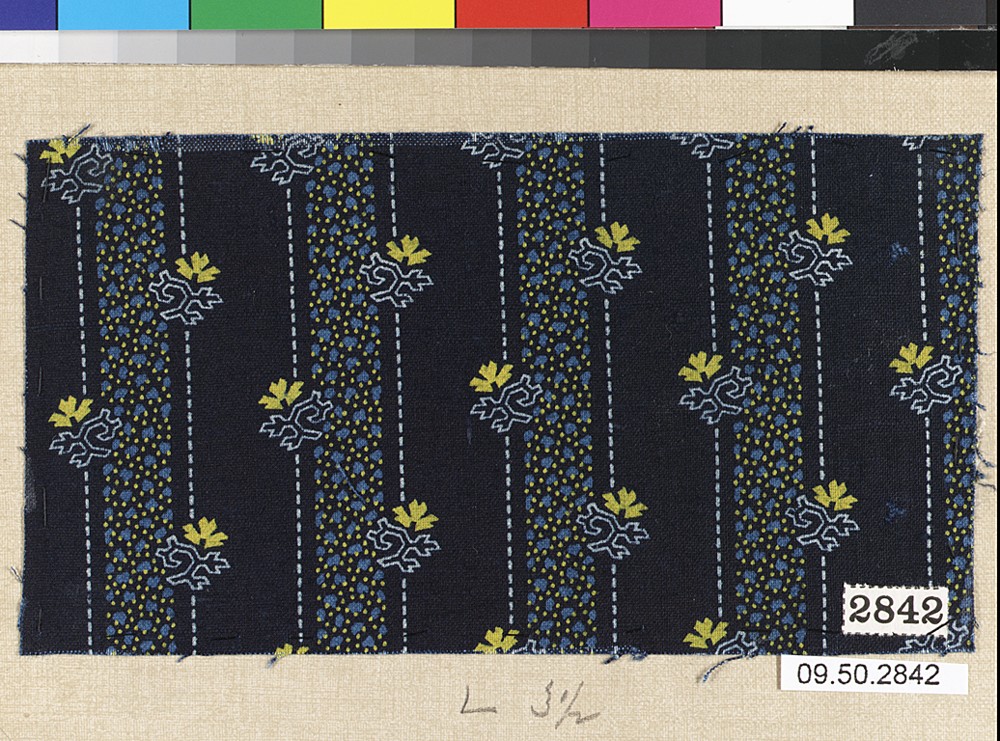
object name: piece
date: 1801-1900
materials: cotton